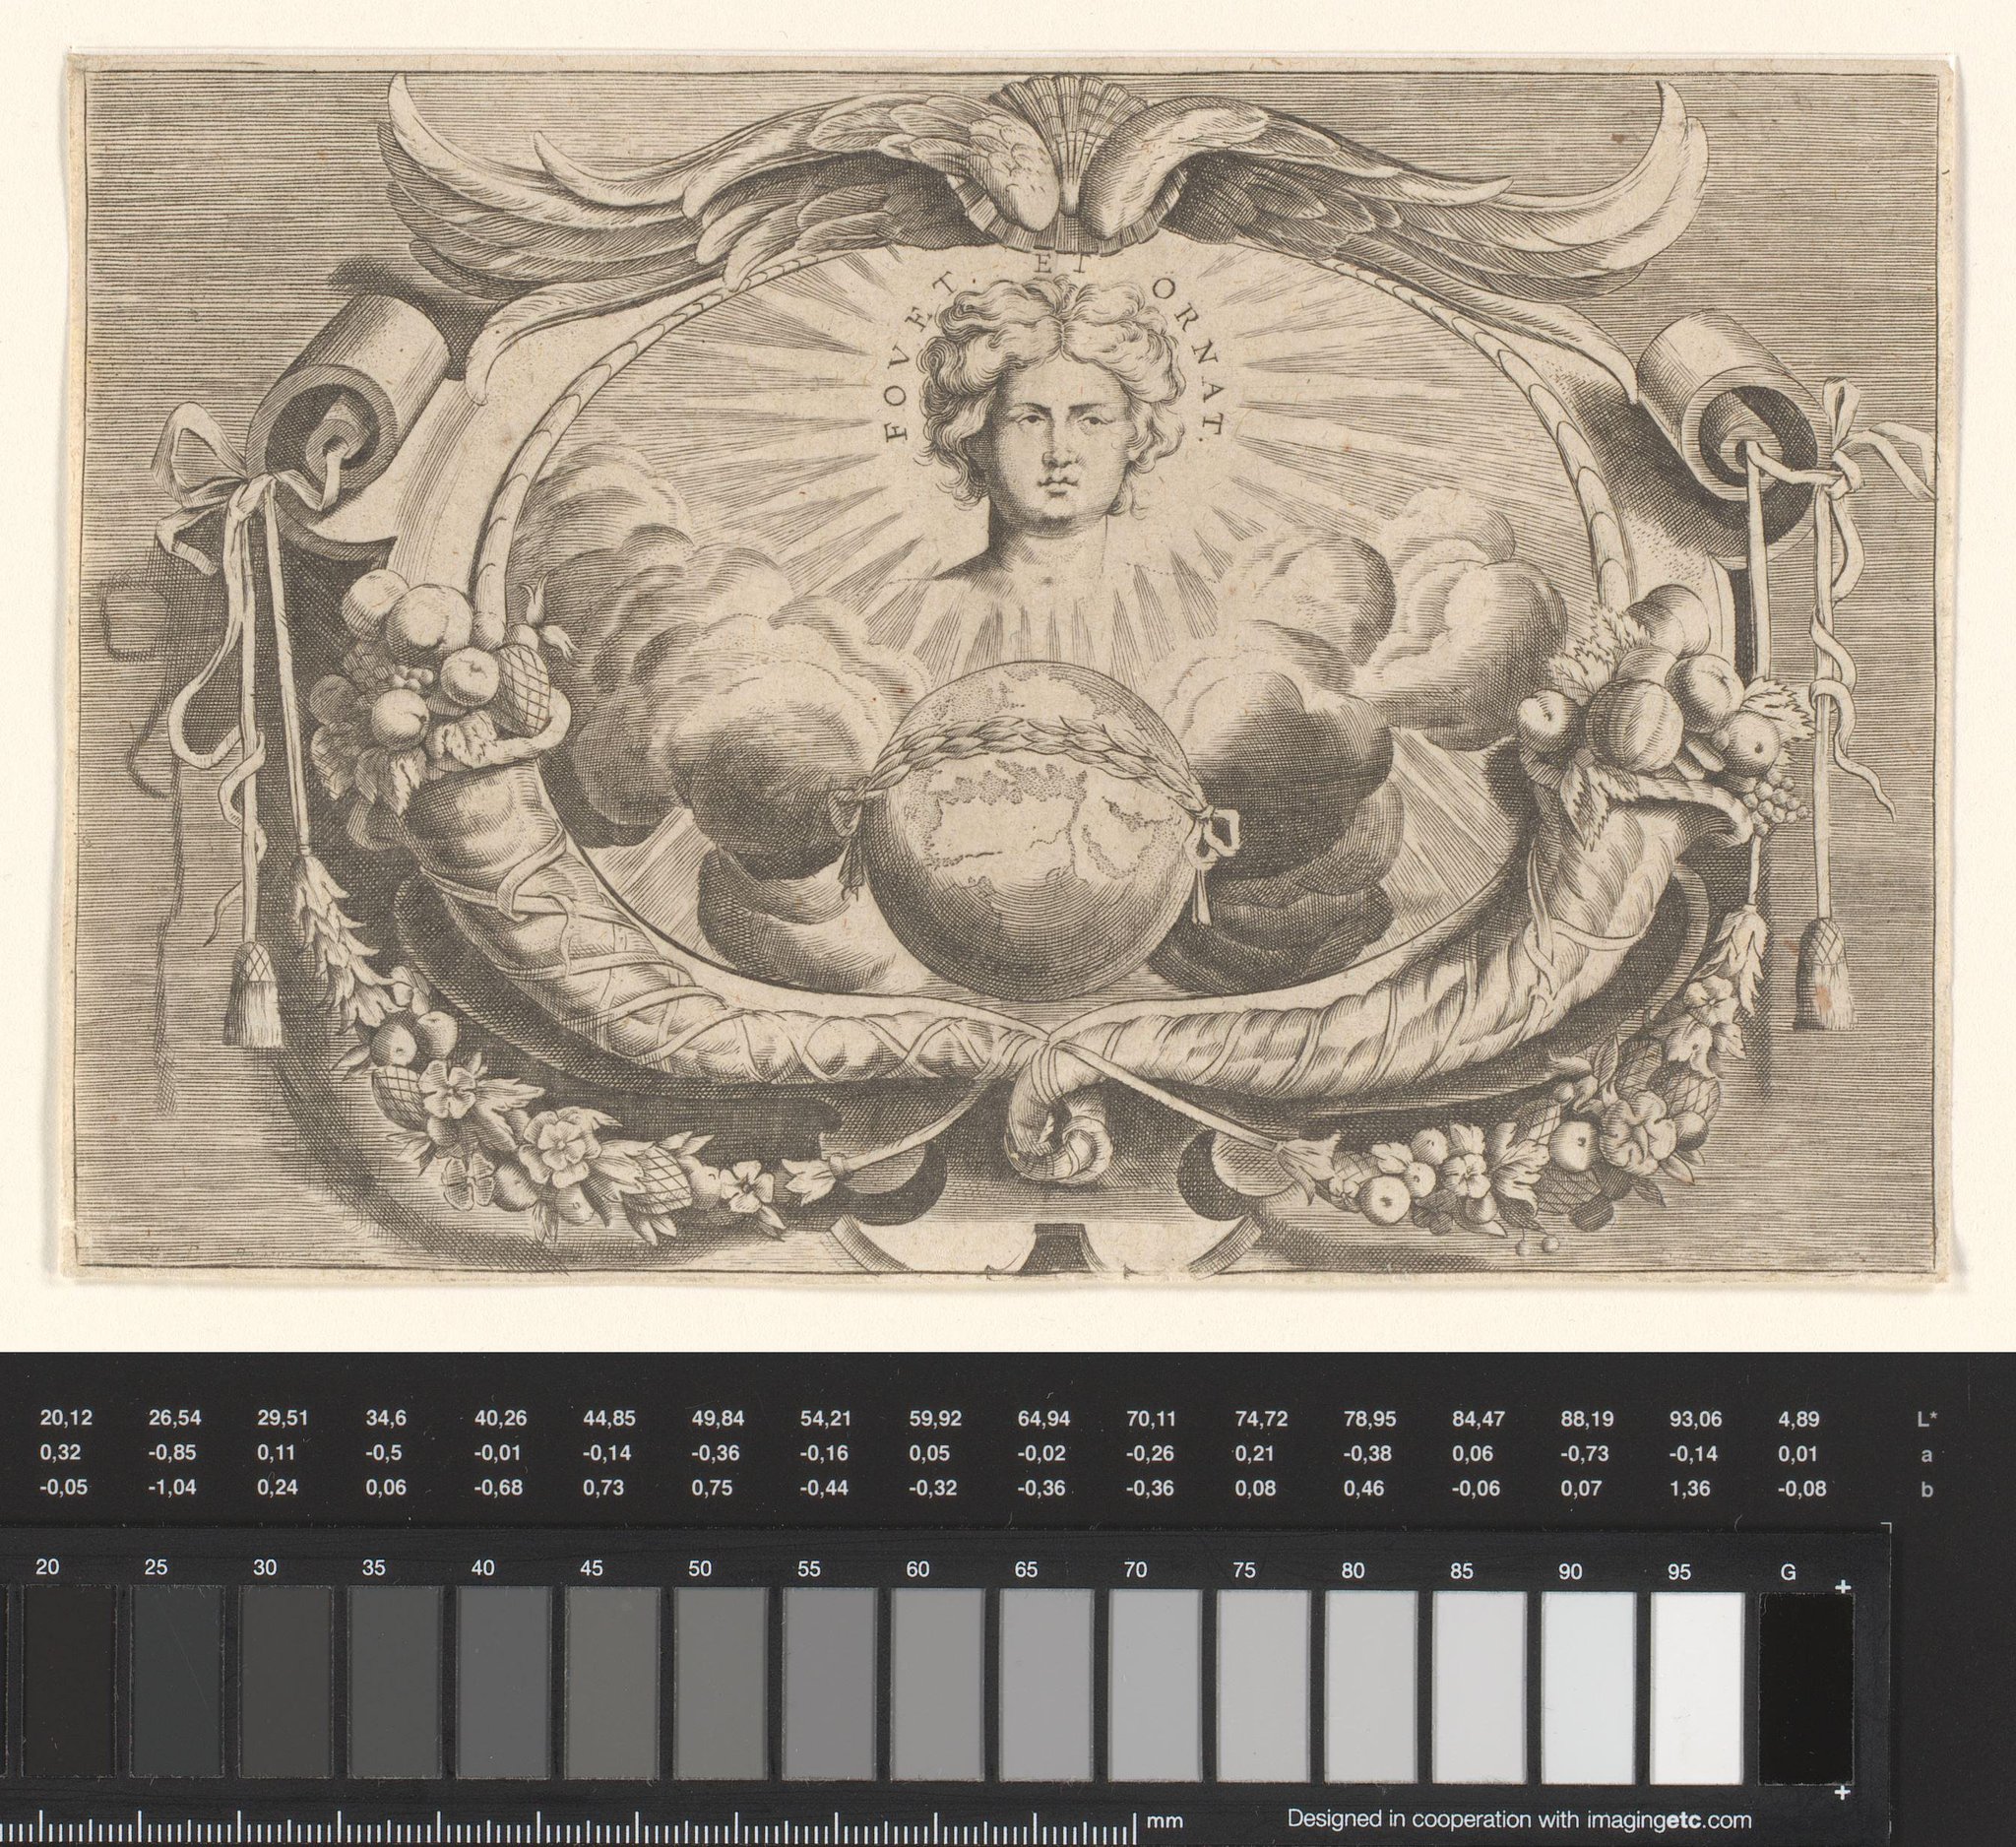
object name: print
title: Drukkersmerk 'Fovet et Ornat' van Jan van Keerberghen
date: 1617-1624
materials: paper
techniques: engraving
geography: antwerp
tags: 'cornucopia', horn of plenty, garland, wreath, sun represented as face, wheel, etc., scallop, shell ~ ornament, ornament ~ cartouche, globe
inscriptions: inscription: ‘no. 40 - 2’, collector's mark: Lugt 240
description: Hoofd als zon en wereldbol met lauwerkrans in cartouche. Boven de personificatie van de zon het motto 'Fovet et ornat.'. Daaronder een wereldbol met een lauwerkrans. Rondom het cartouche hoornen des overvloeds en vleugels. Drukkersmerk van Jan van Keerberghen.